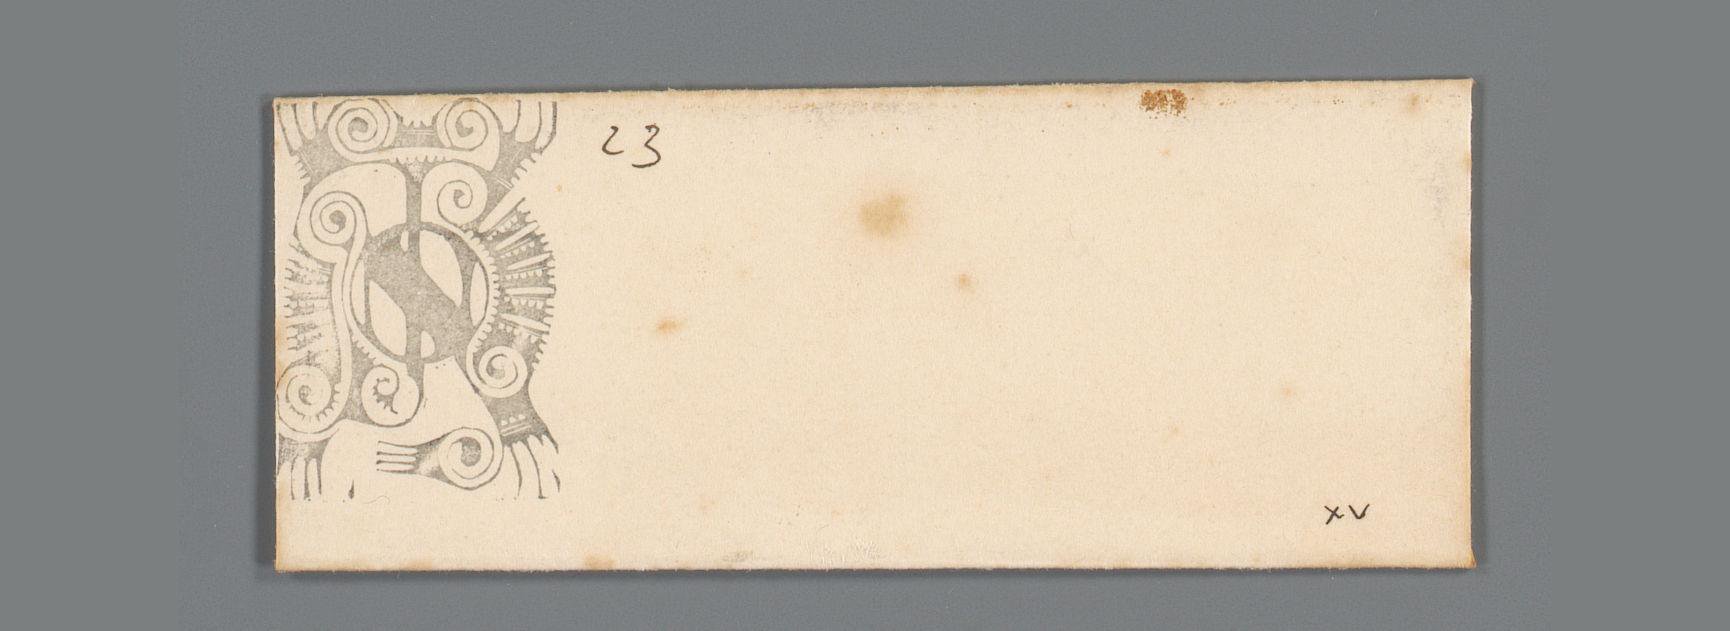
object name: print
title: Envelop met vignet met monogram JN of NJ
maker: karel petrus cornelis de bazel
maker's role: draughtsman, print maker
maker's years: 1869-1923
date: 1890-1900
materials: paper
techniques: woodcut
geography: amsterdam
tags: fantasy ornament, letter combinations such as letterword, anagram, letter square, monogram, etc.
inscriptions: name: ‘B. van Mantgem, Hofl. Singel 562, Amst.’